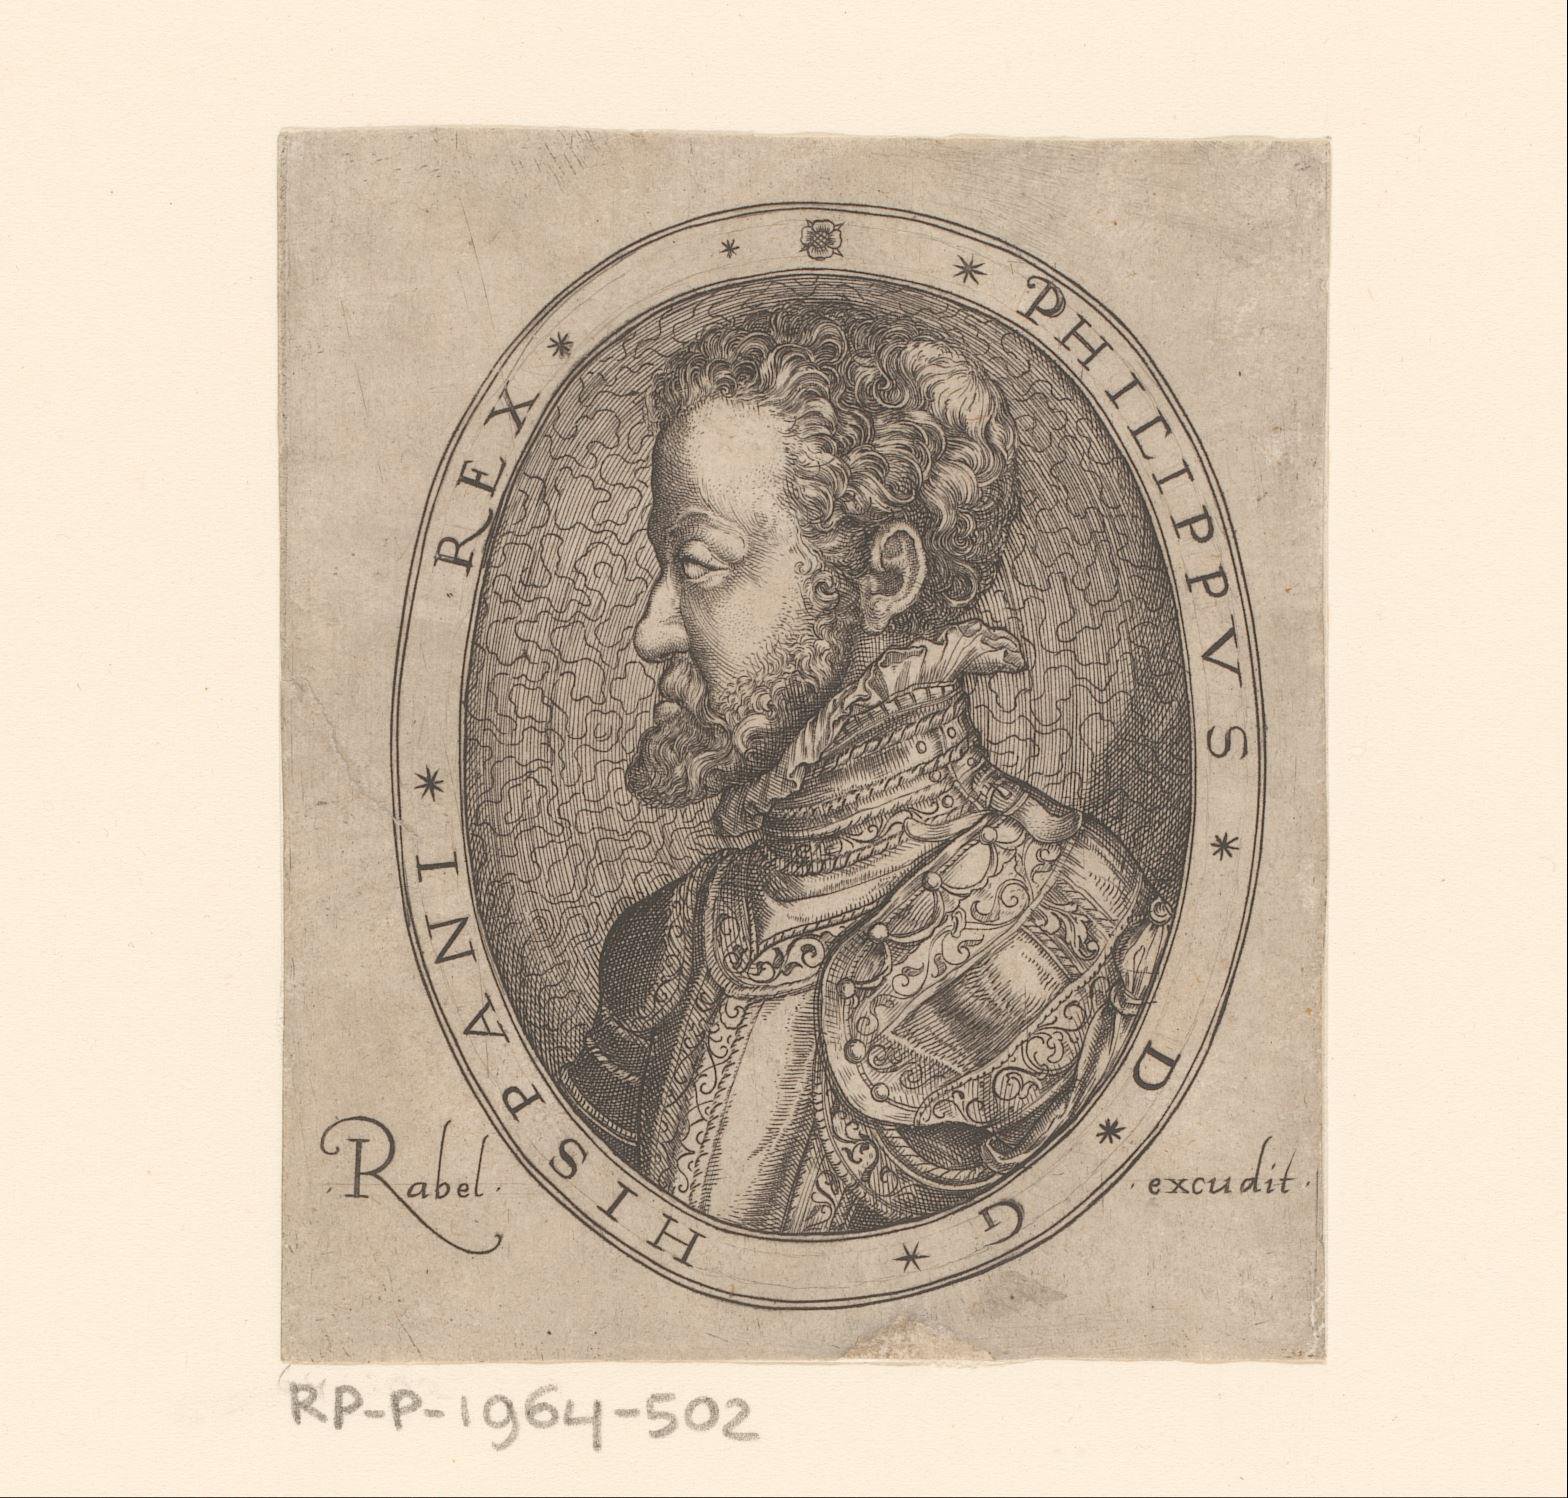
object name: print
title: Portret van Filips II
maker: jean rabel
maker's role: print maker, publisher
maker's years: 1548-1603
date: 1570-1580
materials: paper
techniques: engraving, etching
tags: philip ii of spain, historical persons, king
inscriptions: collector's mark: Lugt 2228